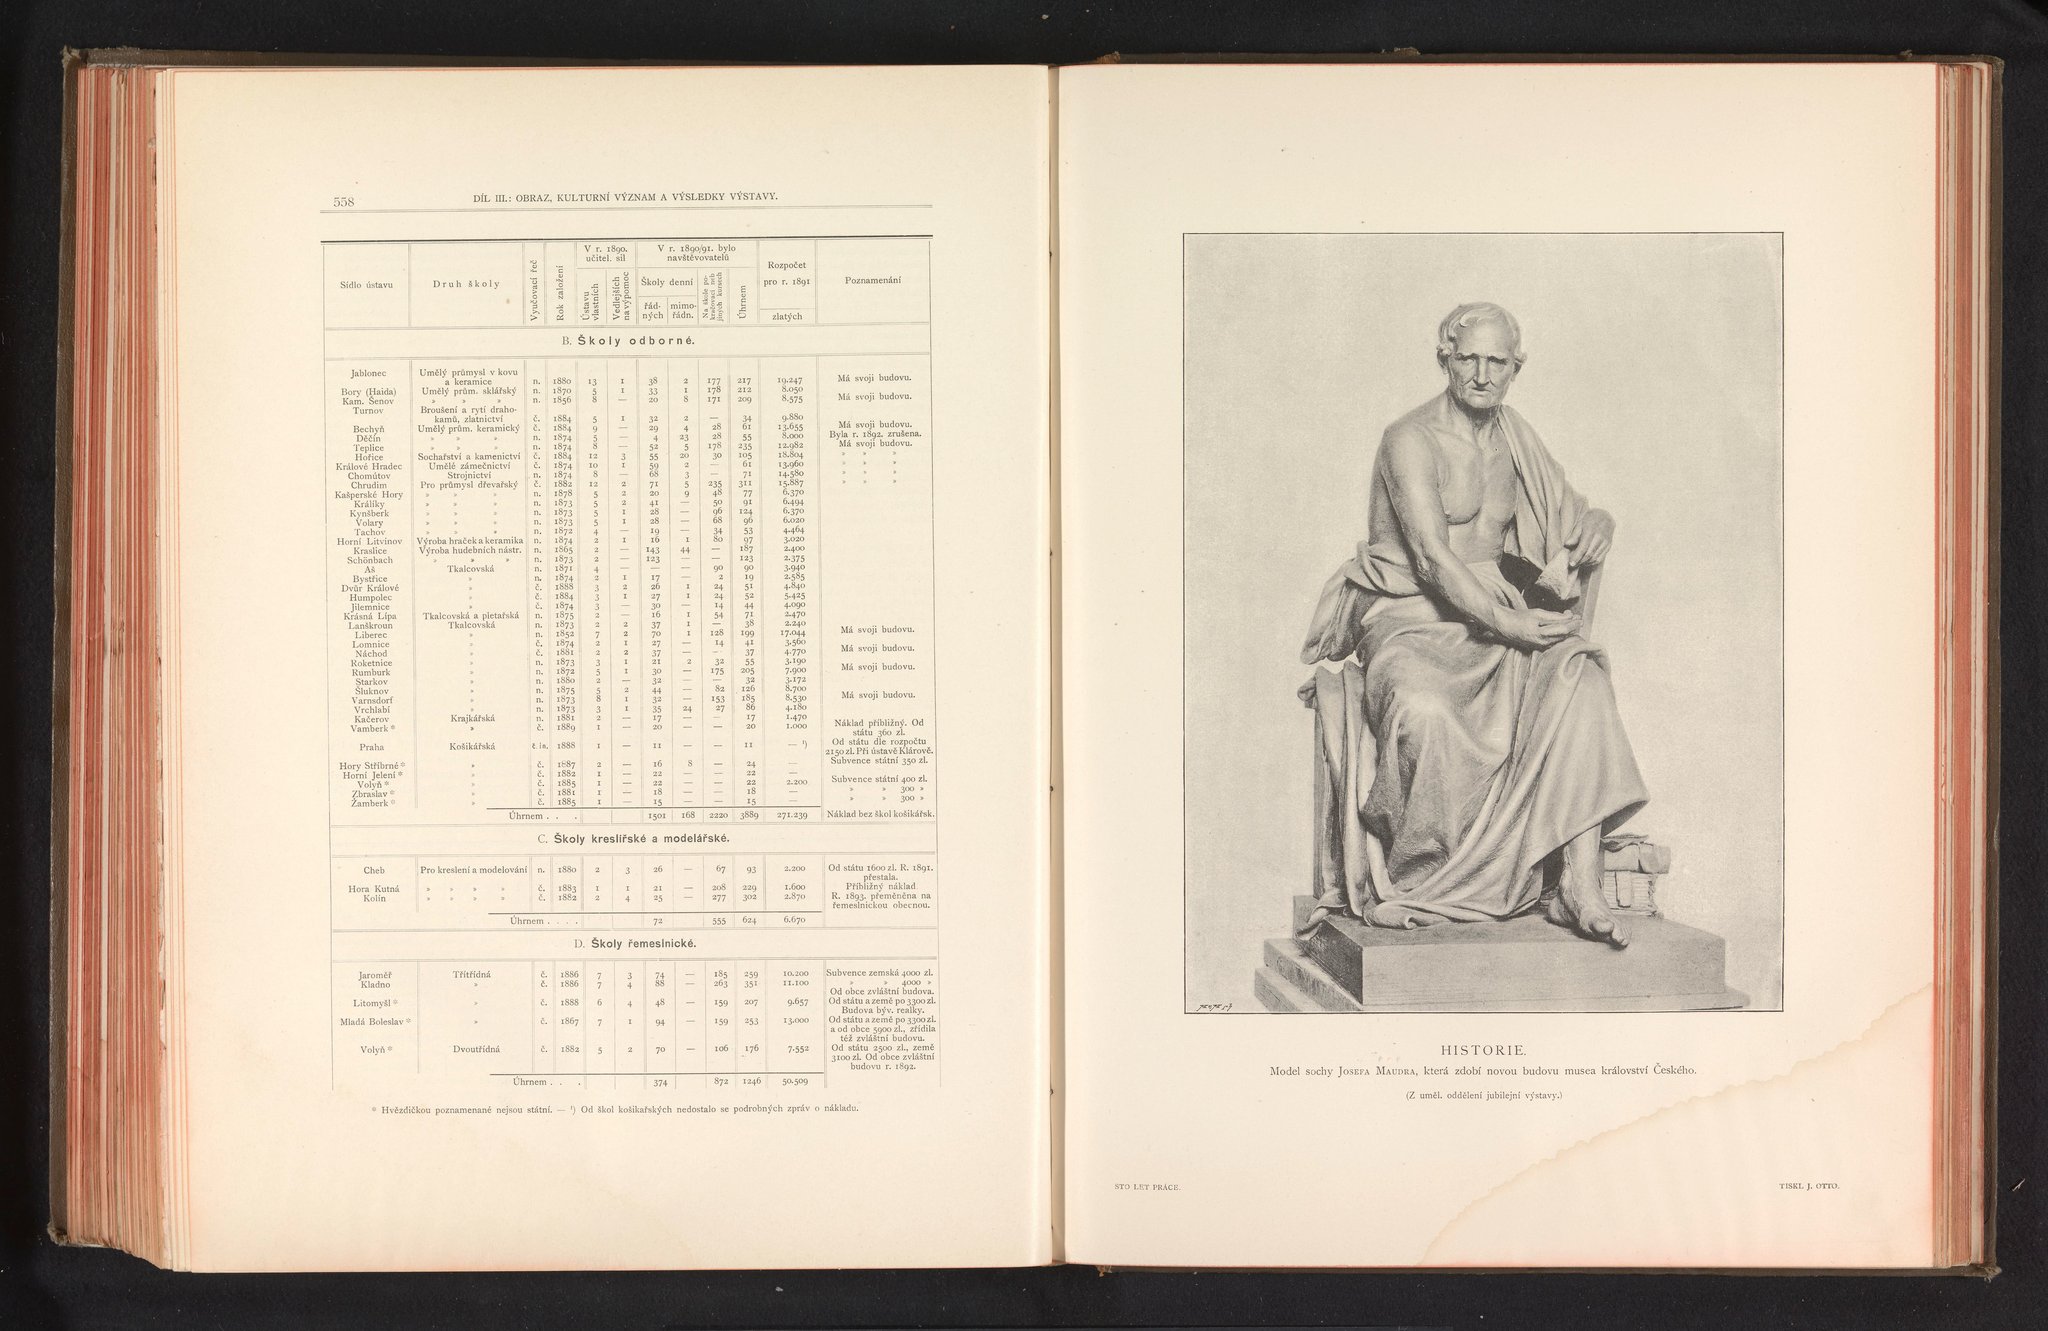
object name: page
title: Sculptuur, voorstellende een personificatie van de geschiedenis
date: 1891-1895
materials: paper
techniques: autotype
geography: prague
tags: history, sculpture